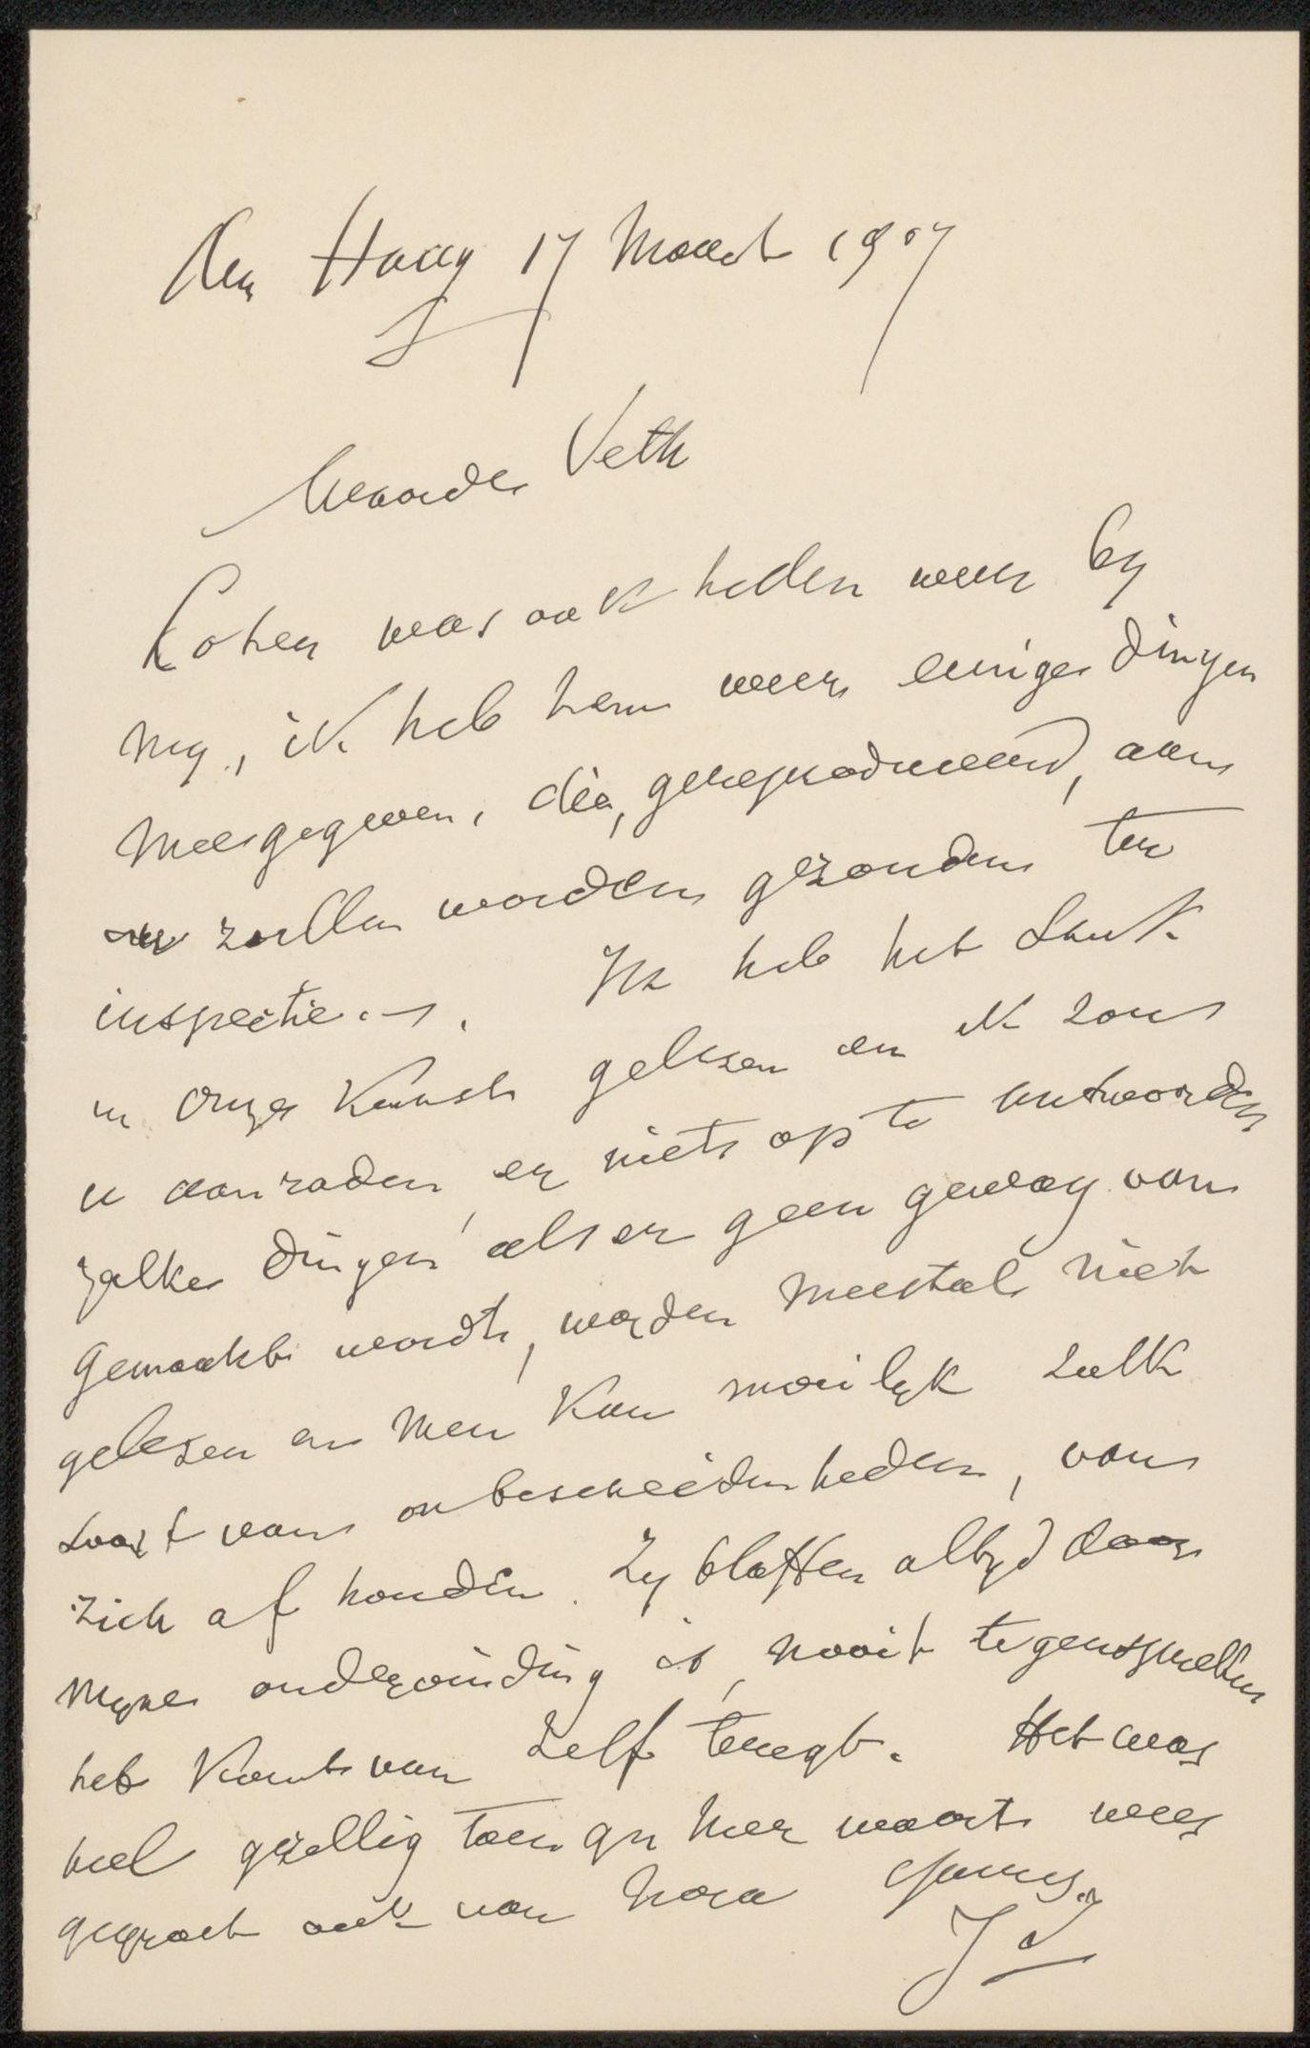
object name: letter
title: Brief aan Jan Veth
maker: jozef israëls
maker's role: draughtsman, painter, print maker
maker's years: 1824-1911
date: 1907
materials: ink, paper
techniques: pen, writing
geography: the hague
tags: dordrecht, amsterdam, designer, jan veth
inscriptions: collector's mark: ‘RPK’, watermark